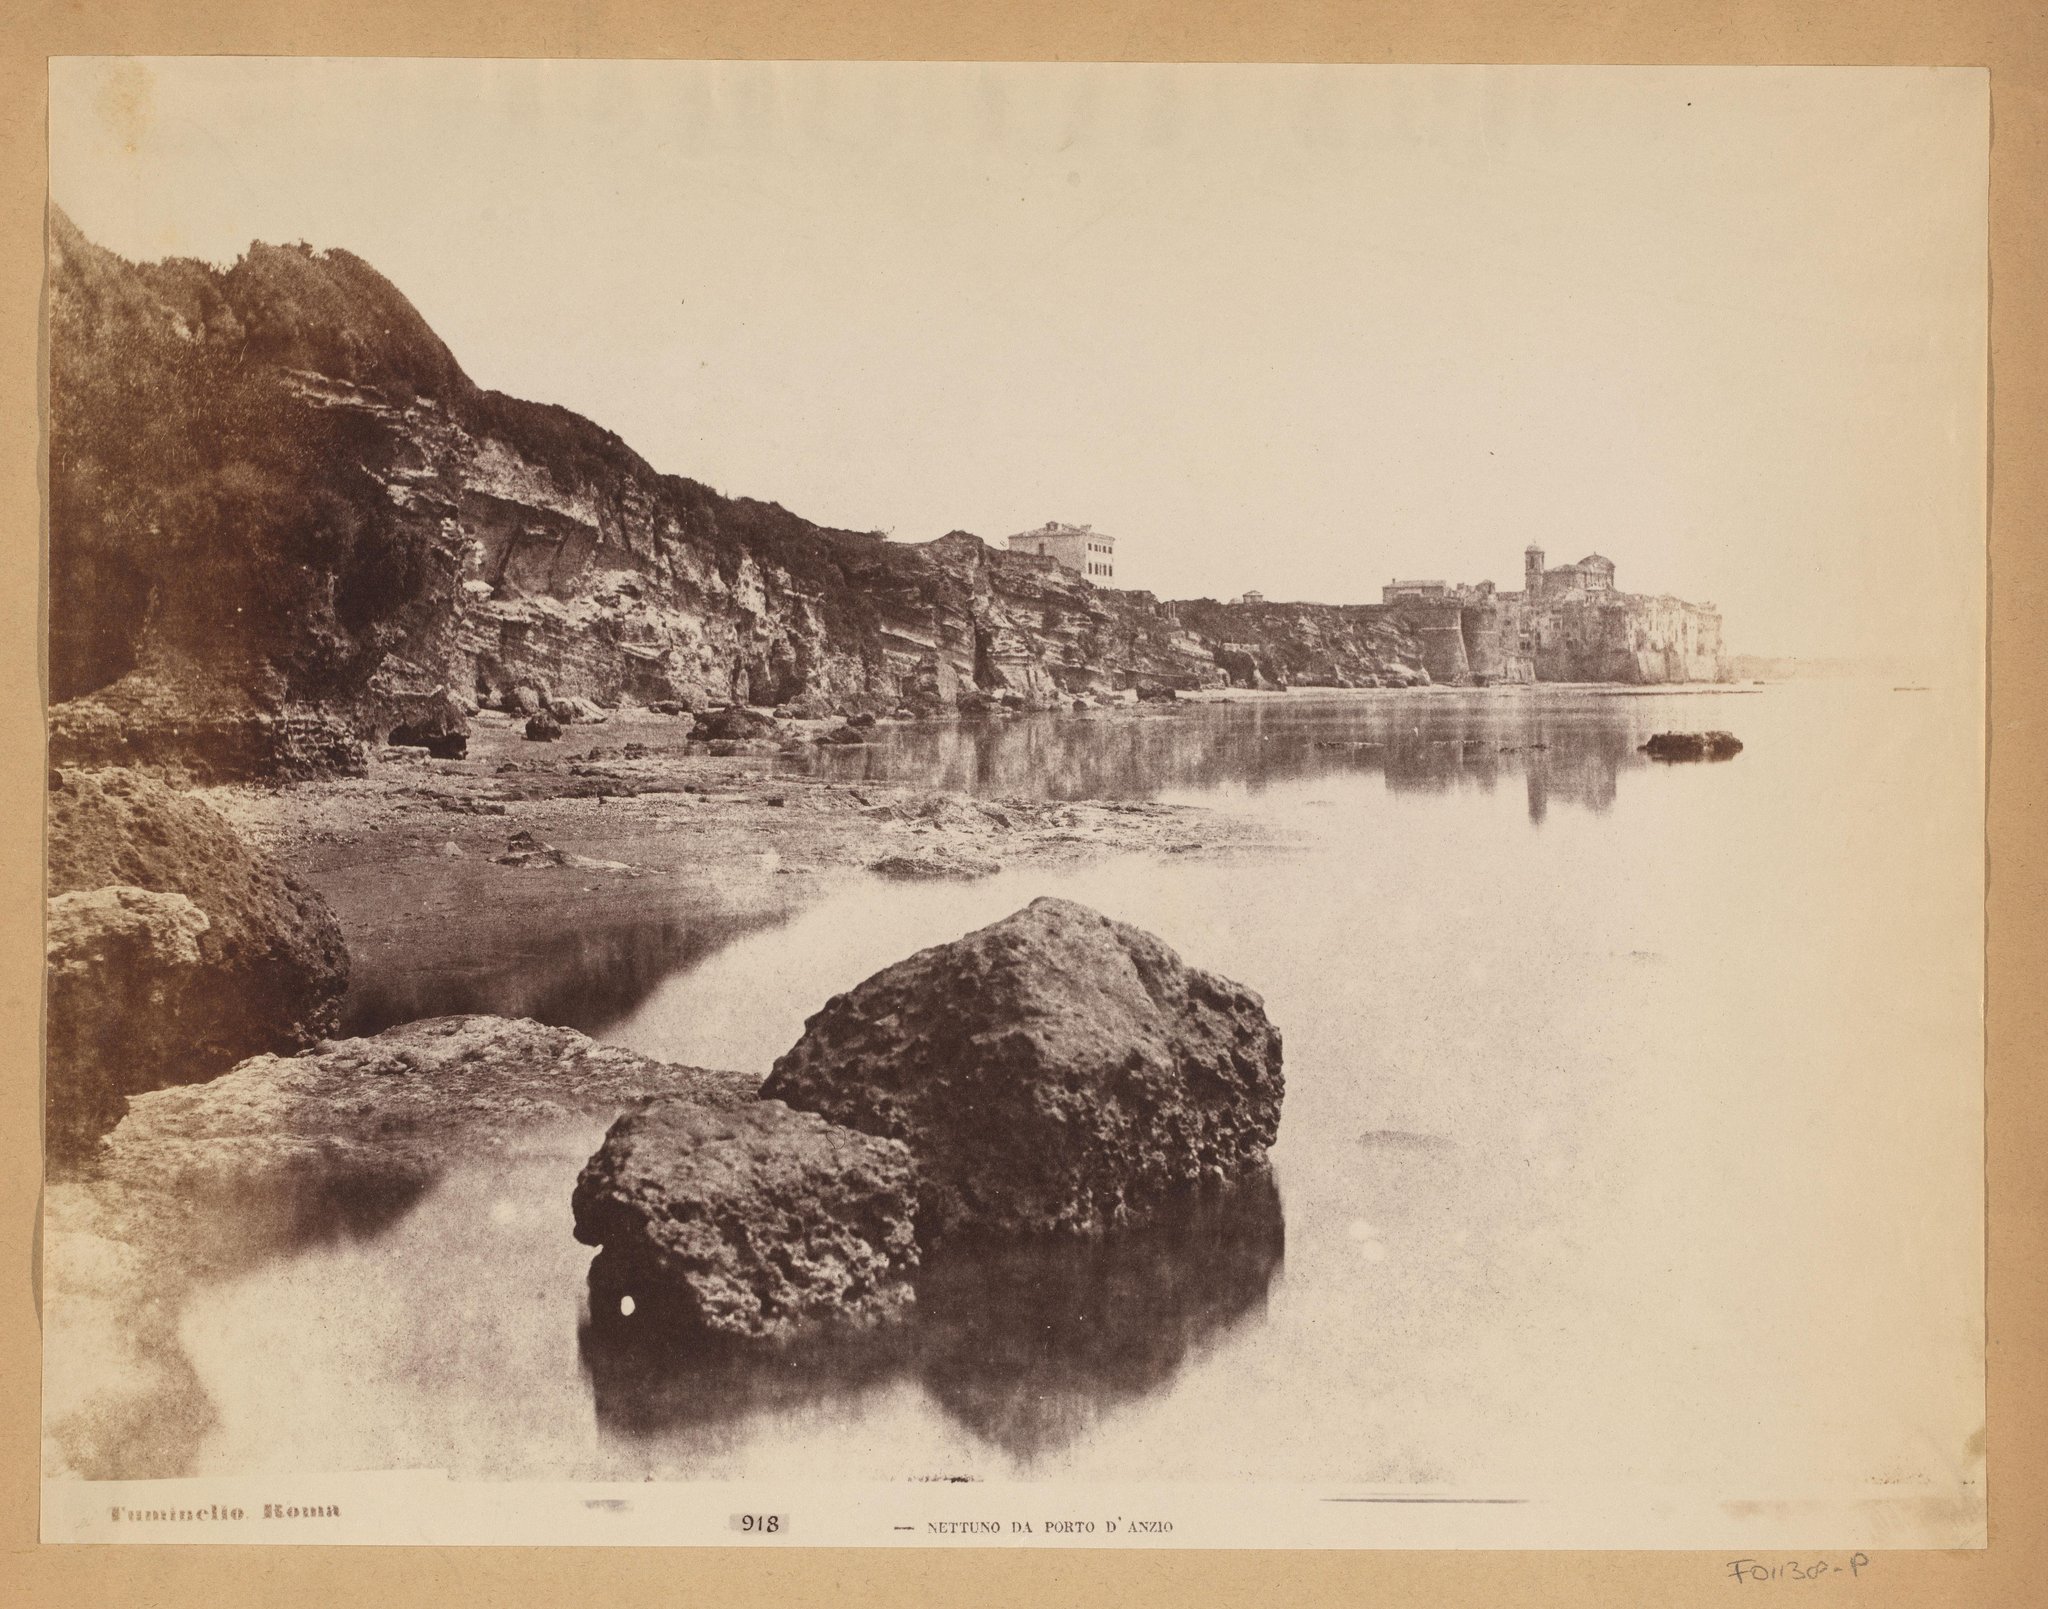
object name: photograph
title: Rotskust bij Nettuno, gezien vanaf Porto d'Anzio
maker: ludovico tuminello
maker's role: fotograaf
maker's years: 1824-1907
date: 1860-1900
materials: photographic support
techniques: albumen print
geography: nettuno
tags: prospect of village, silhouette of village, coastal cliff or crag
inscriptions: number: ‘918’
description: Onderdeel van Reisalbum met opnames van kunstwerken en bezienswaardigheden in Italië, Griekenland en Frankrijk.